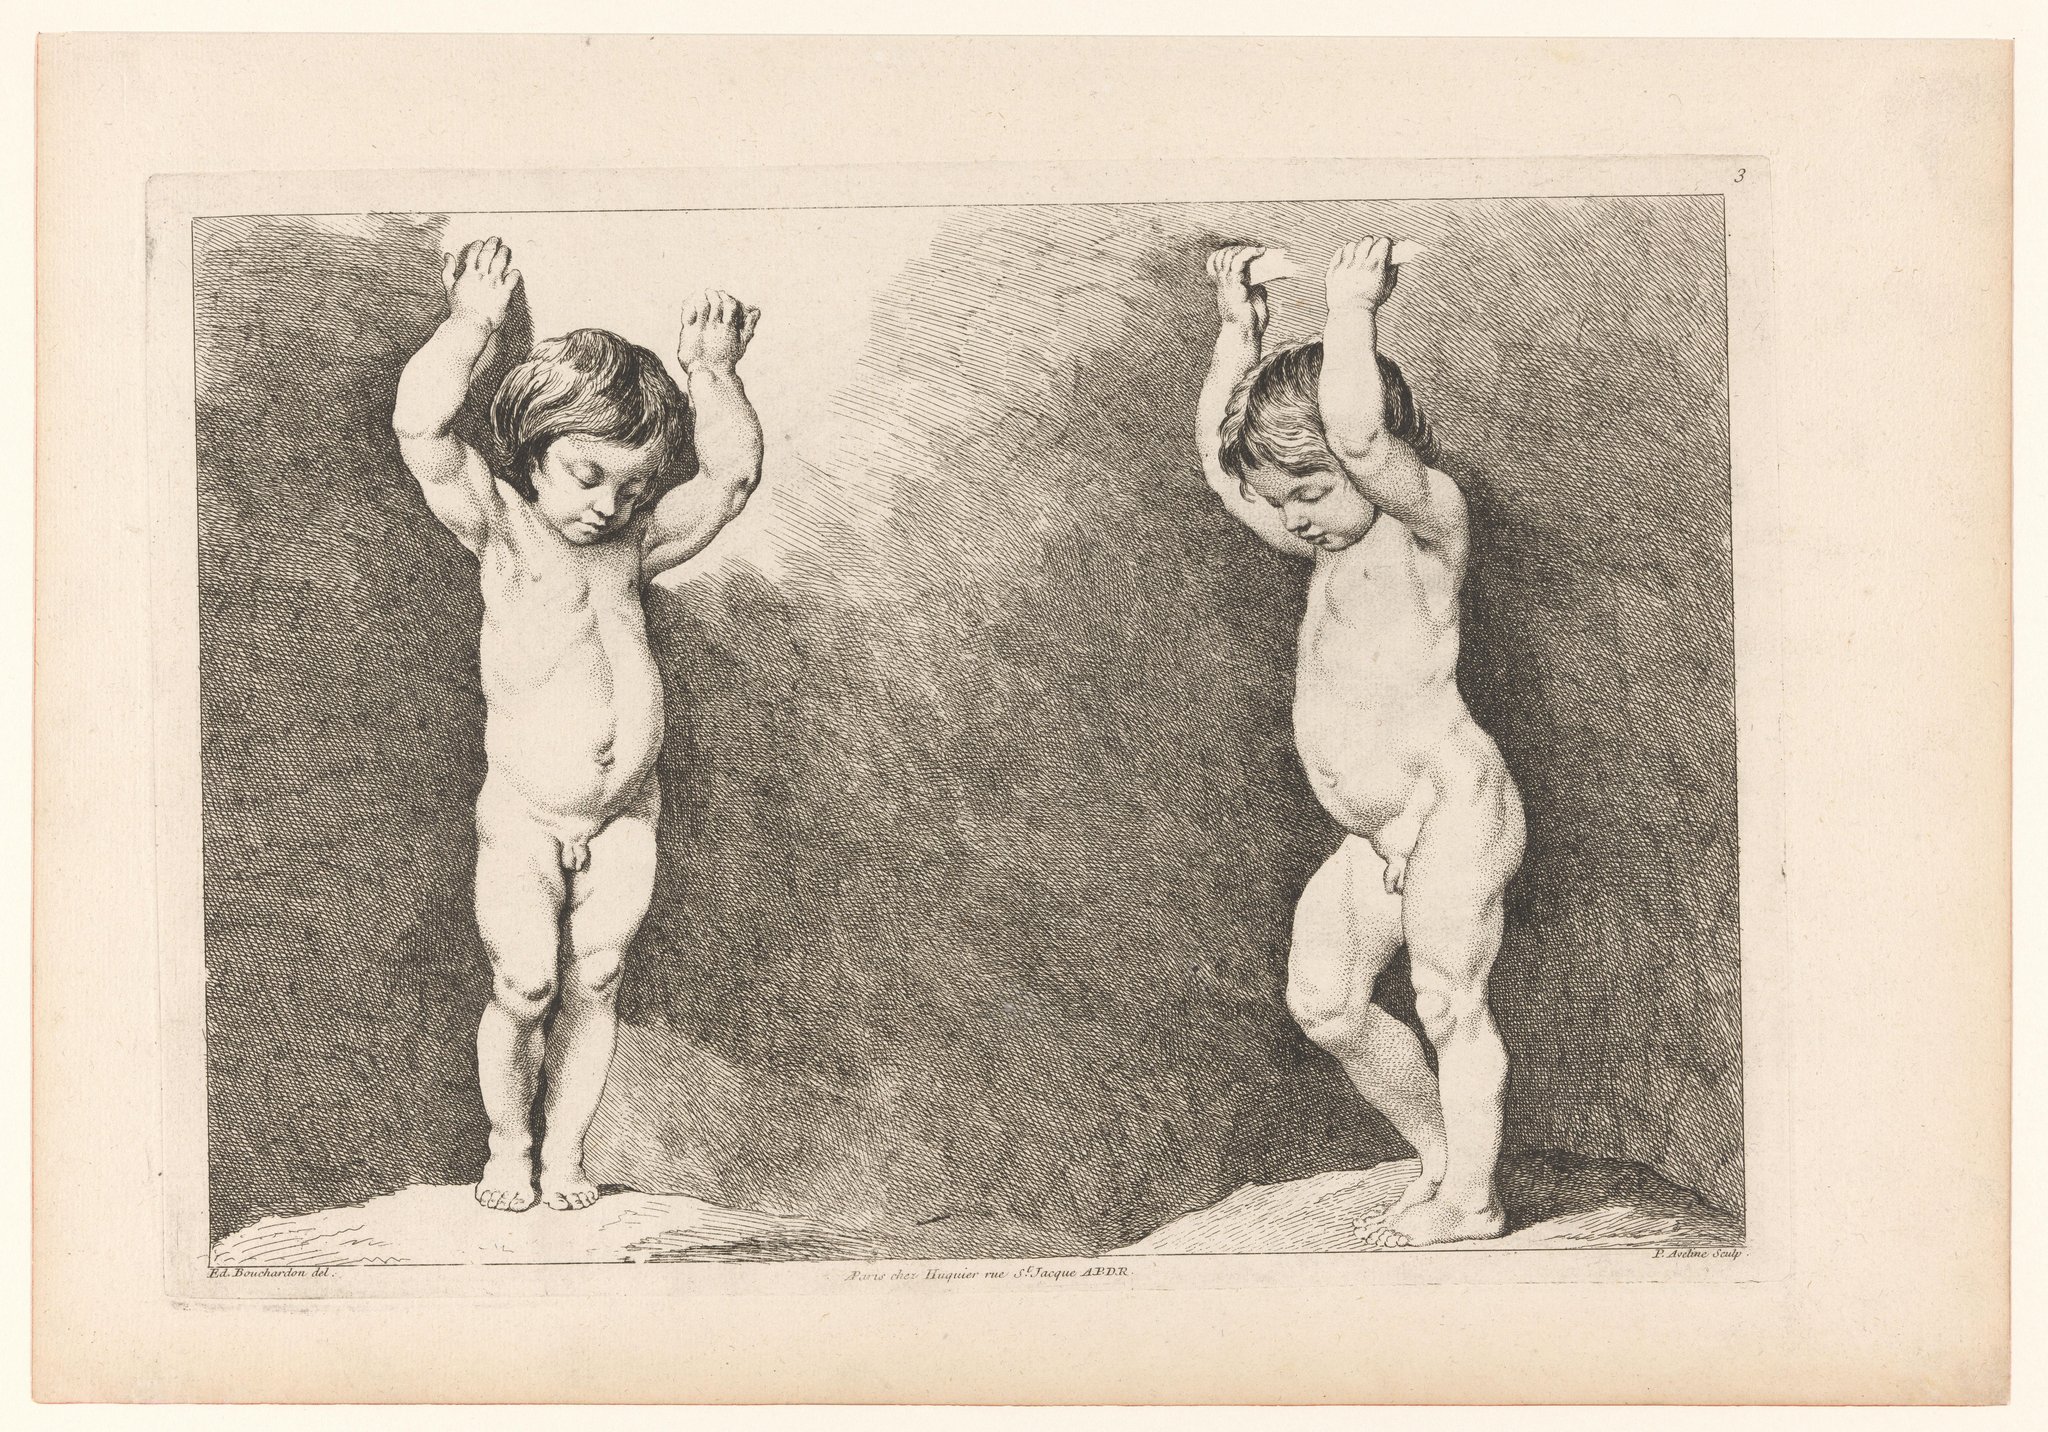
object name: print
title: Twee jongetjes met de armen omhoog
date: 1742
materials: paper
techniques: etching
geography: paris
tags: standing figure (+ young male (human being))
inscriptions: collector's mark: Lugt 2760, collector's mark: Lugt 2228, number: ‘3’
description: Twee jongetjes met de armen omhoog. Onderdeel van de serie studies van kinderen.